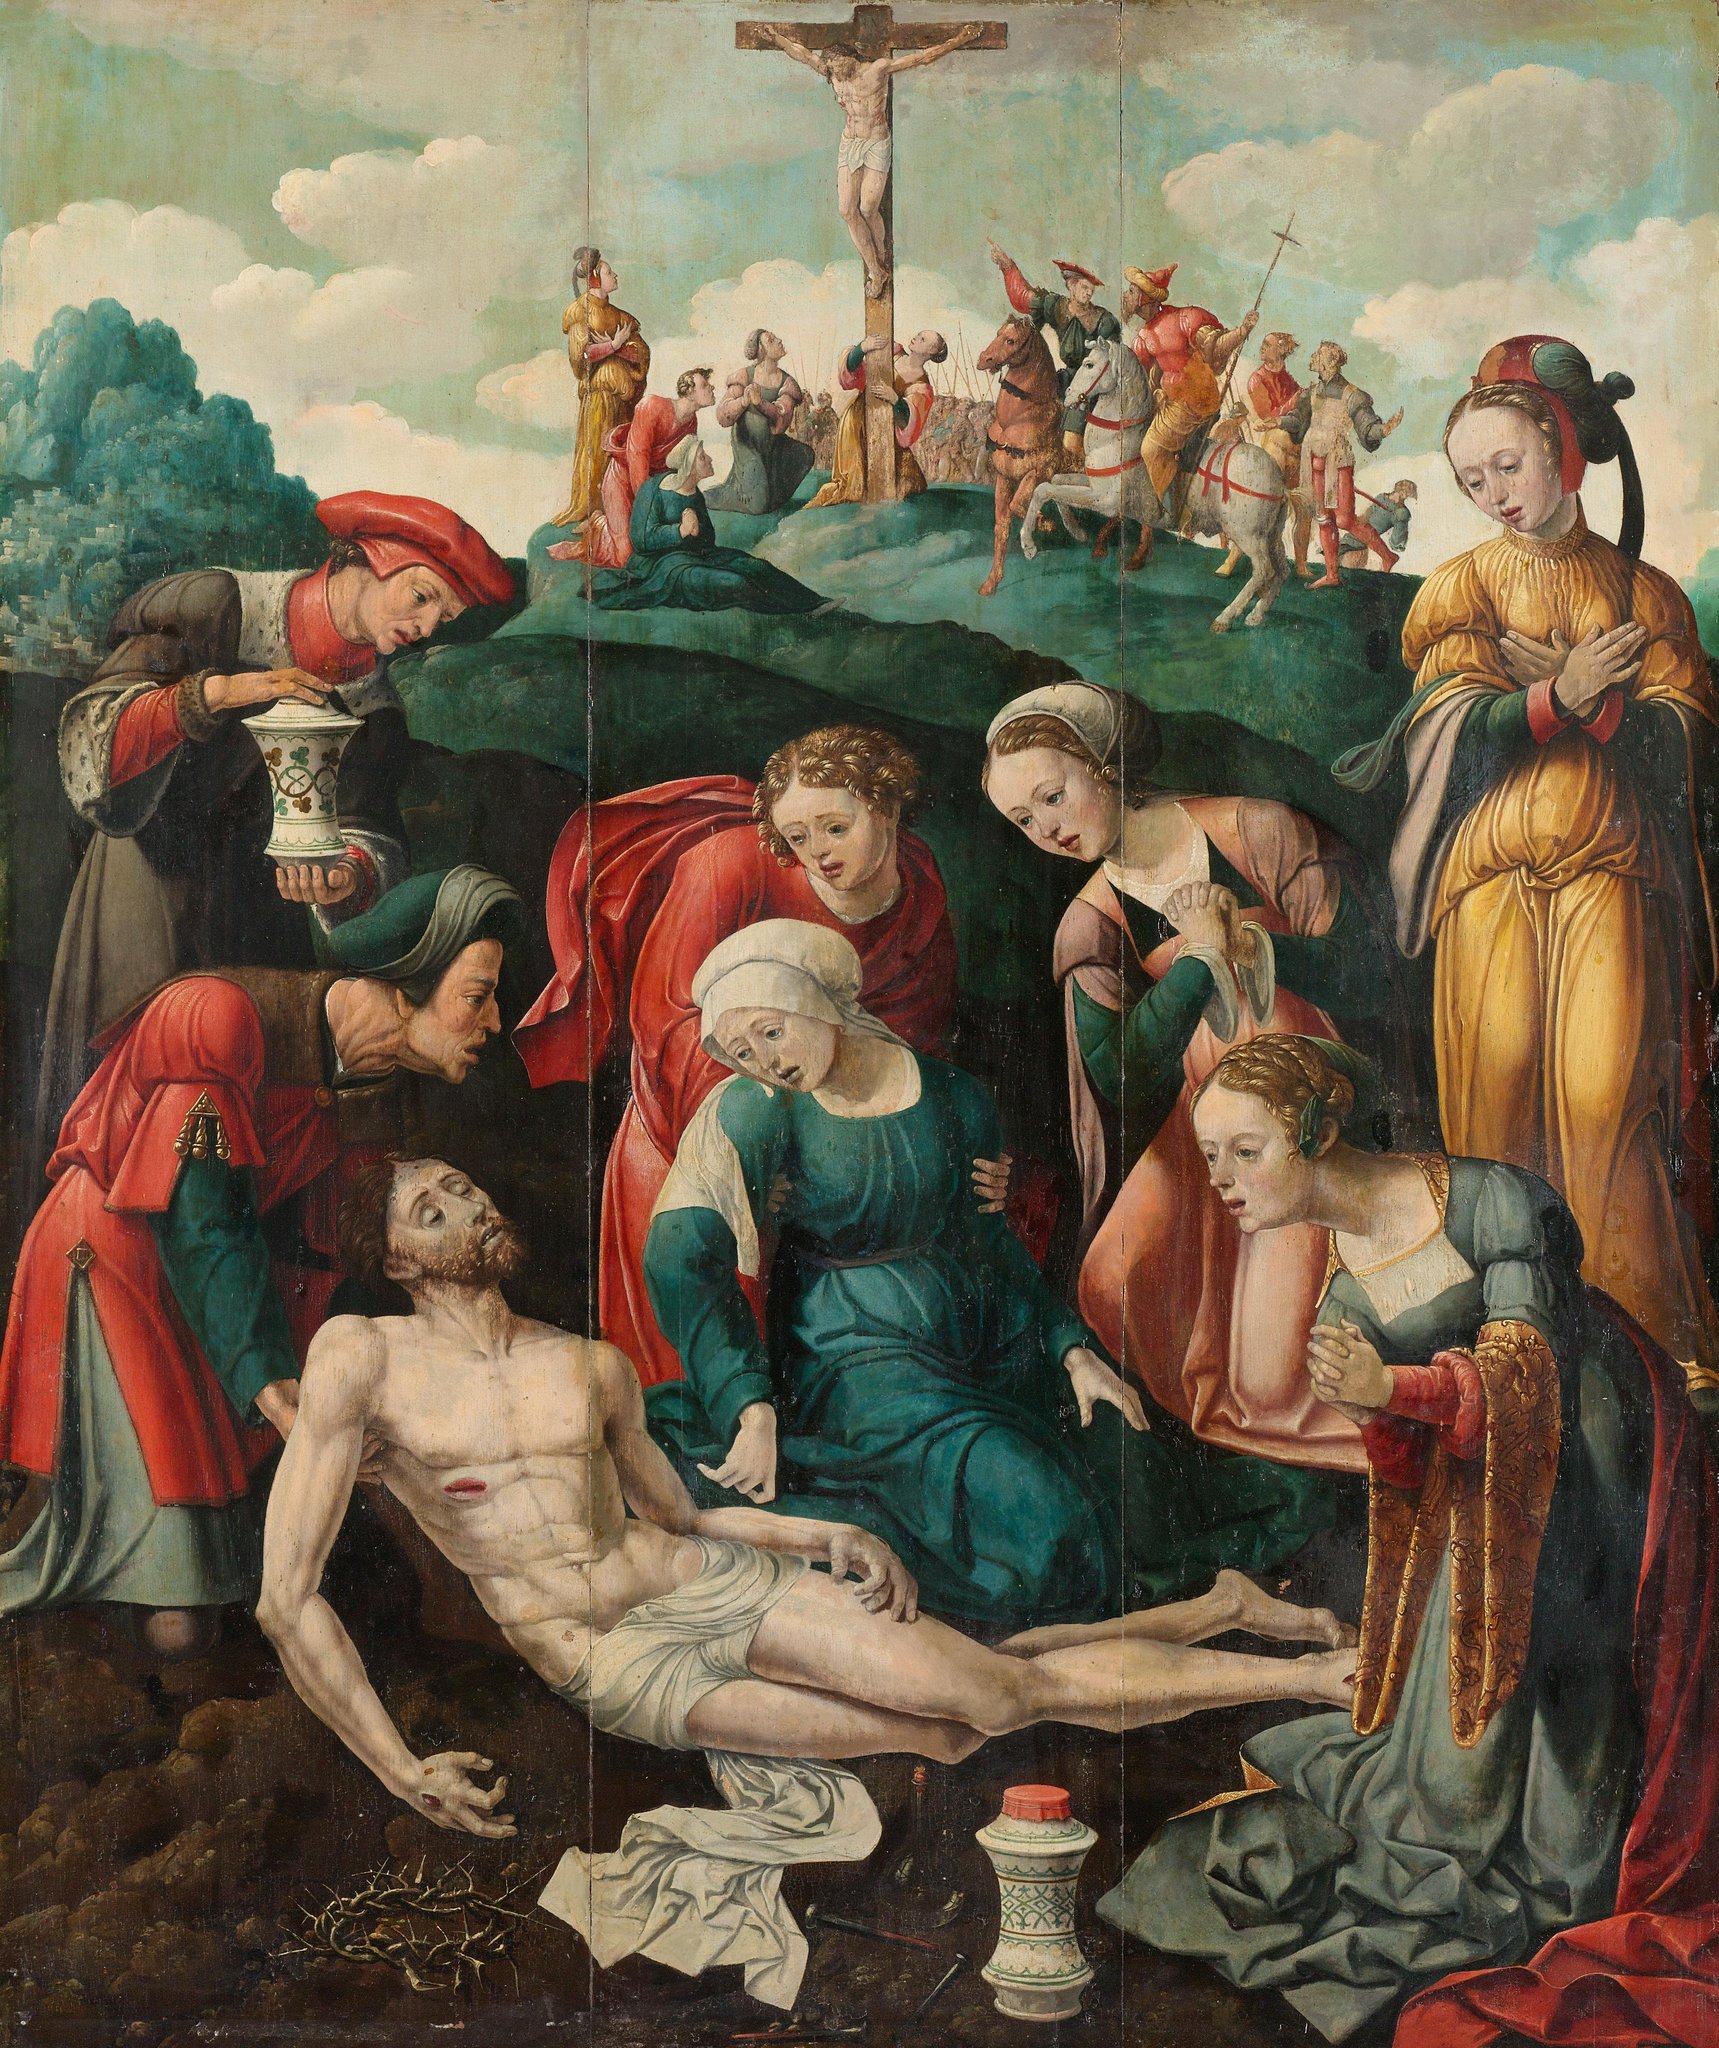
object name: painting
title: The Lamentation of Christ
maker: cornelis cornelisz ii buys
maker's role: draughtsman, painter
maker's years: 1500-1546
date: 1530-1540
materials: oil, panel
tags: christ on the cross; only scenes following the crucifixion added - dd - the three crosses, lamentation over the dead christ by his relatives and friends (christ usually without crown of thorns)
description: De bewening van Christus. Het lichaam van Christus is van het kruis gehaald en wordt ondersteund door Jozef van Arimathea. Rechts ondermeer Maria, Johannes en Maria Magdalena. Op de voorgrond een zalfpot en de doornenkroon. Op de achtergrond Christus aan het kruis.